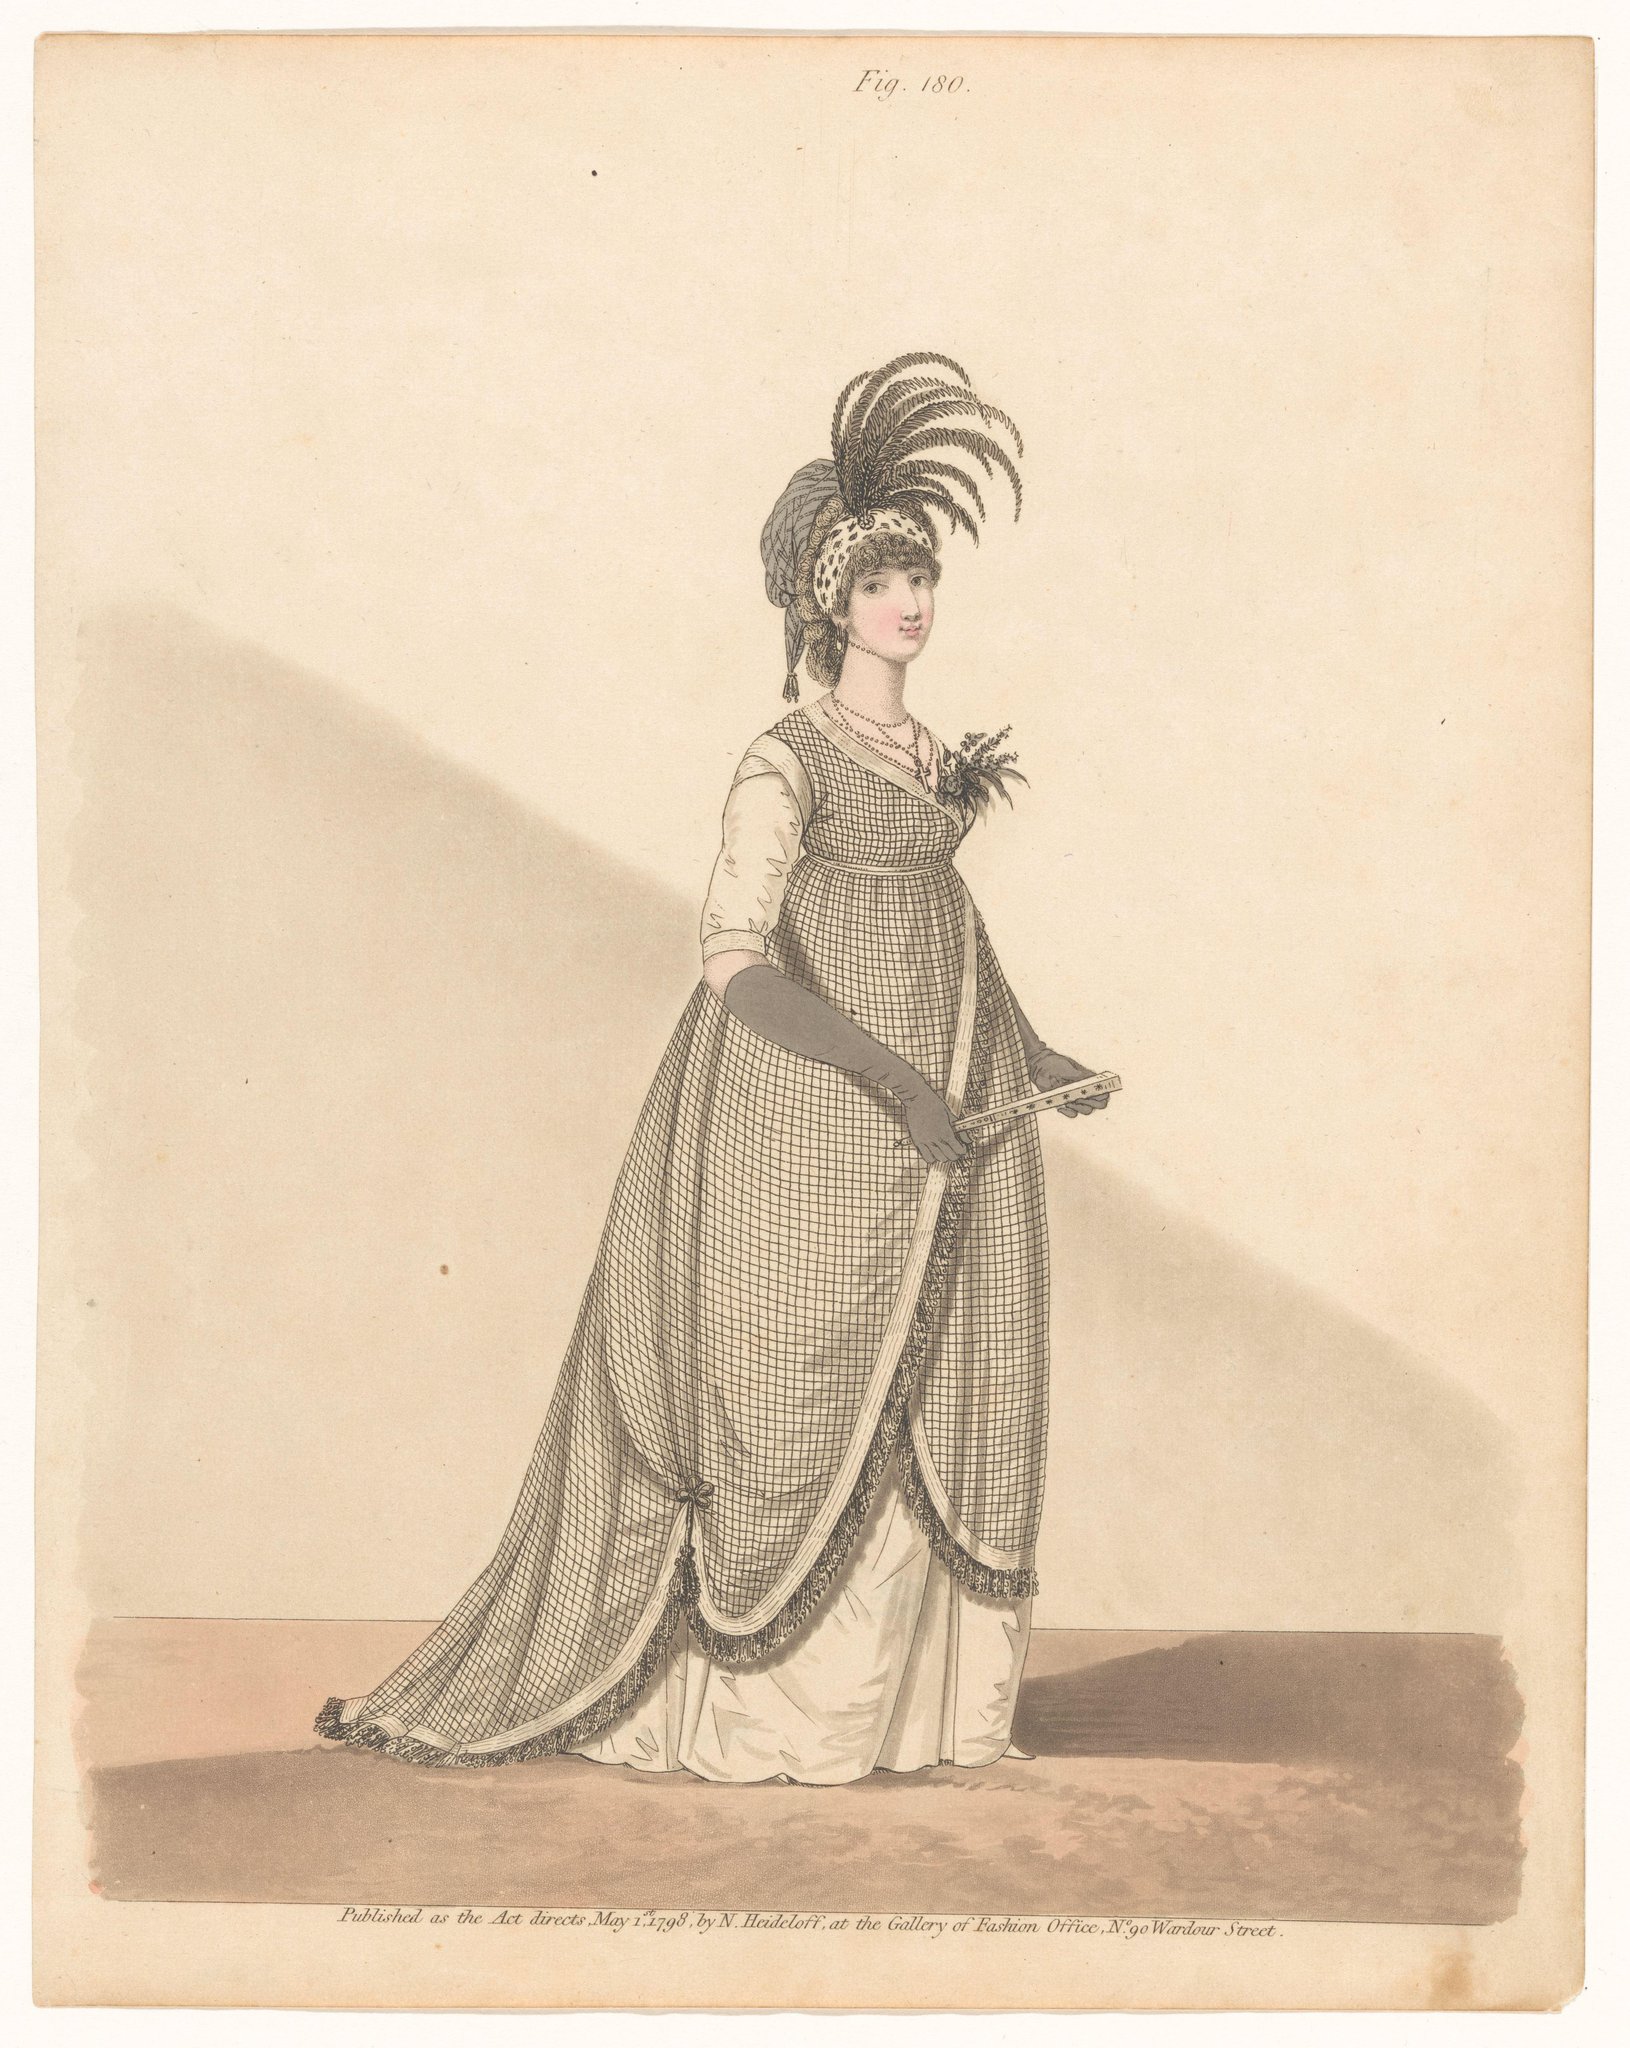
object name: fashion print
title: Gallery of Fashion, Fig. 180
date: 1798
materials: paper, ink, watercolor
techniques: aquatint, etching, hand coloring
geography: london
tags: fashion plates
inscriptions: collector's mark: Lugt 2228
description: Staande vrouw in geruite japon met waaier.